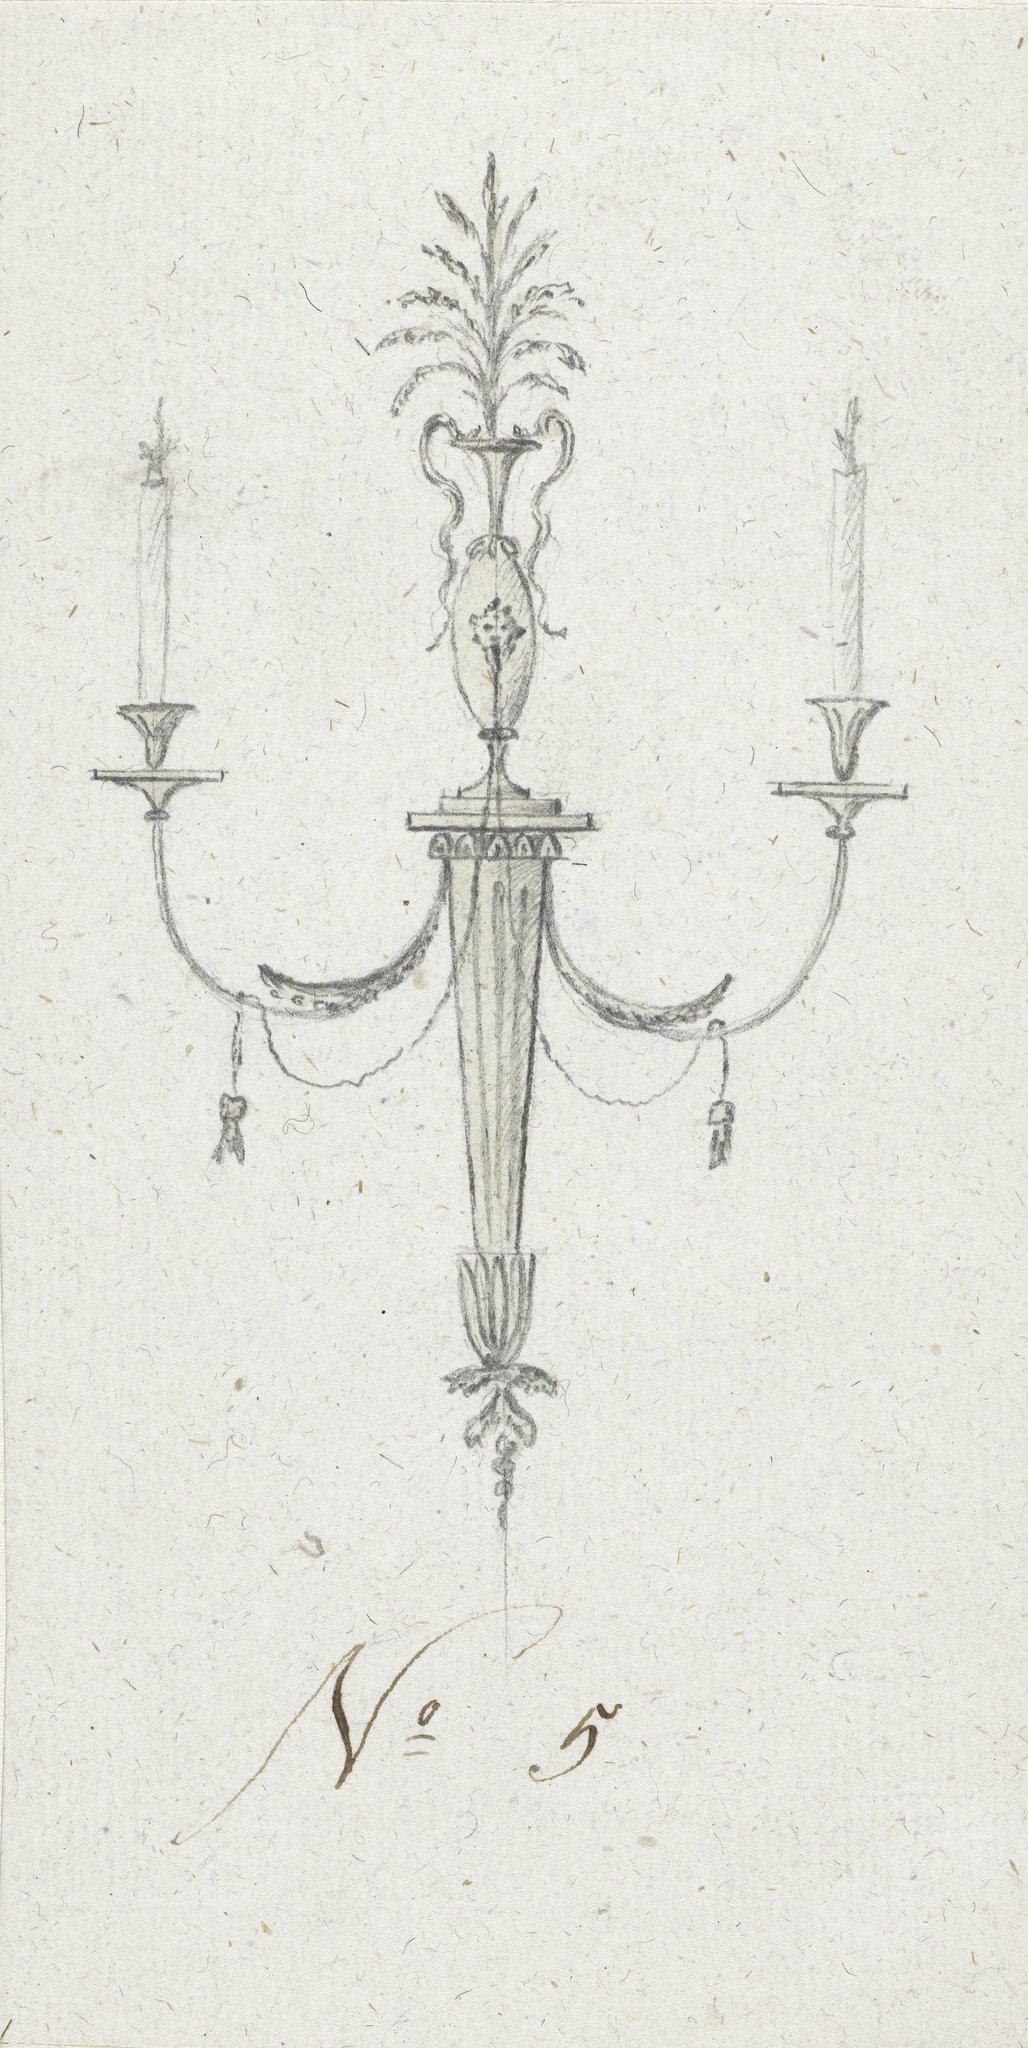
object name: drawing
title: Ontwerp voor een kandelaar (No. 5)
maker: abraham meertens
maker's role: draughtsman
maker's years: 1757-1823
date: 1767-1823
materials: paper, pencil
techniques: brush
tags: sconce, wall lamp